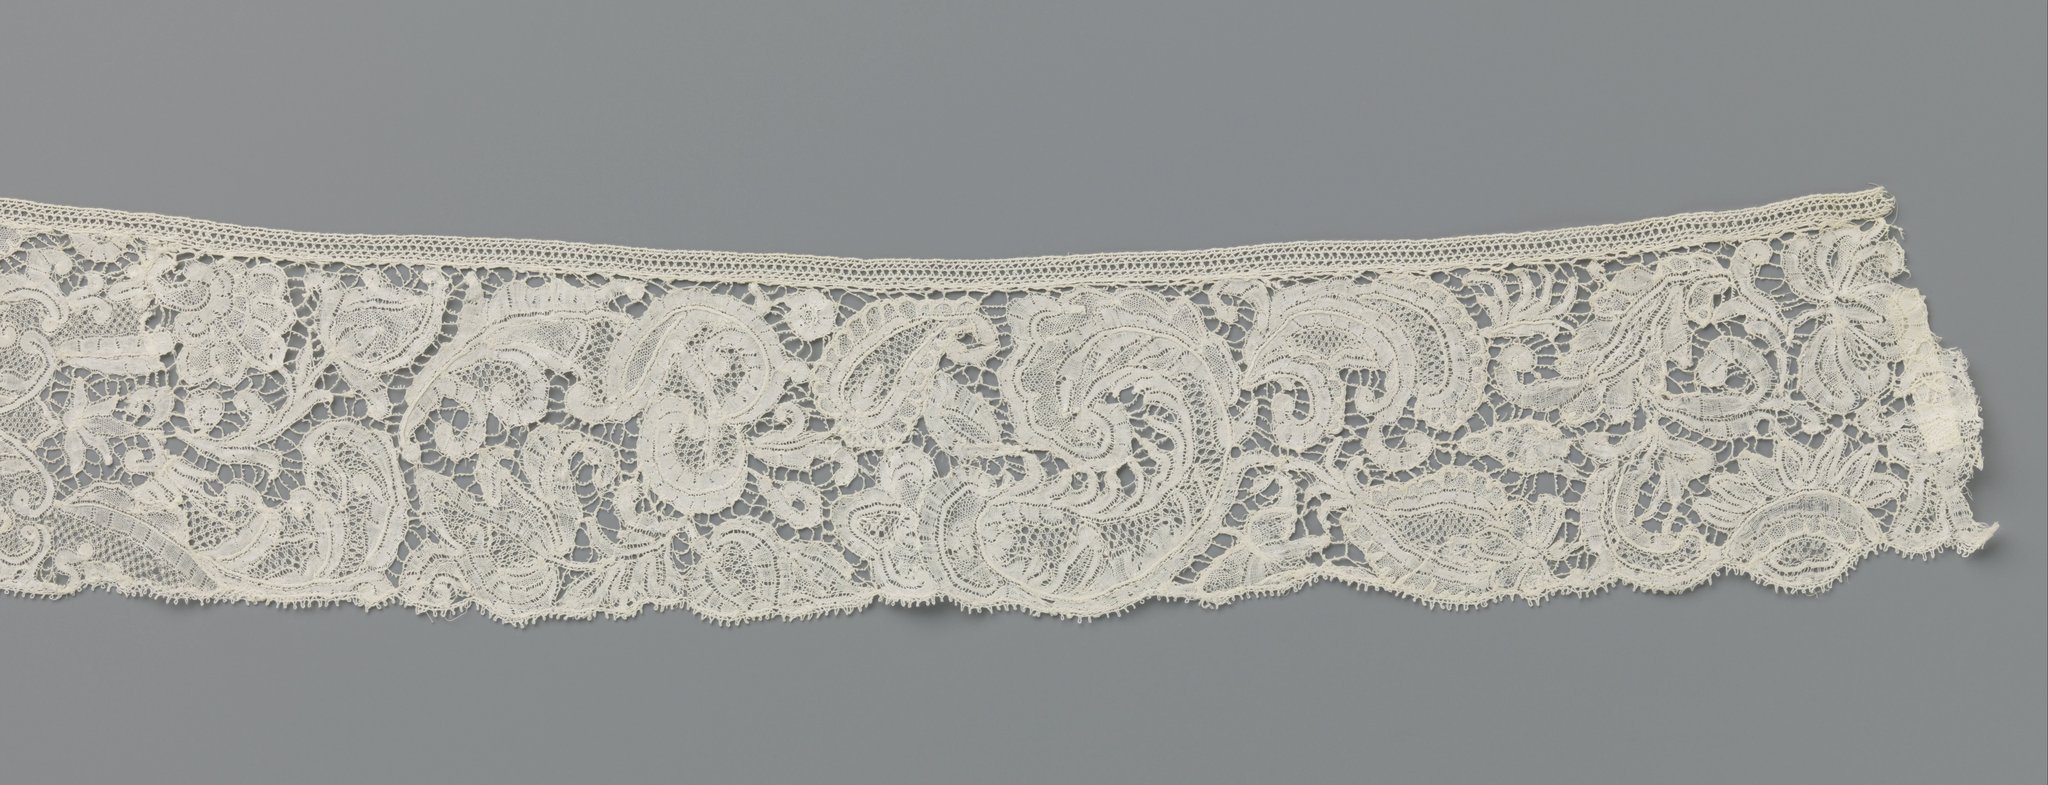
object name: strip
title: Strook kloskant met rijke symmetrische bloemencomposities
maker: Anonymous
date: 1740-1760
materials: linen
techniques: lace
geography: brussels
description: Strook naturelkleurige Brusselse kloskant. Het patroon bestaat uit verschillende symmetrische composities met grote bloemen, bladeren en voluten. Er is een grote rijkdom aan blad- en bloemvormen te zien. De motieven zijn met elkaar verbonden door gepicoteerde vlechten. De motieven zijn gemaakt in linnenslag met uitsparingen en opengewerkte randjes en met netslagvullingen. Verschillende motieven zijn voorzien van gekloste reliëfcontouren. Er zijn verschillende siergronden toegepast, waaronder fijne sneeuwvlokkengronden, rozengronden en fijne maasgronden versierd met vierkantjes gemaakt in vormslag. De bovenzijde is afgewerkt met een apart geklost bandje. De onregelmatig geschulpte onderzijde komt voort uit het patroon en is afgewerkt met picots.